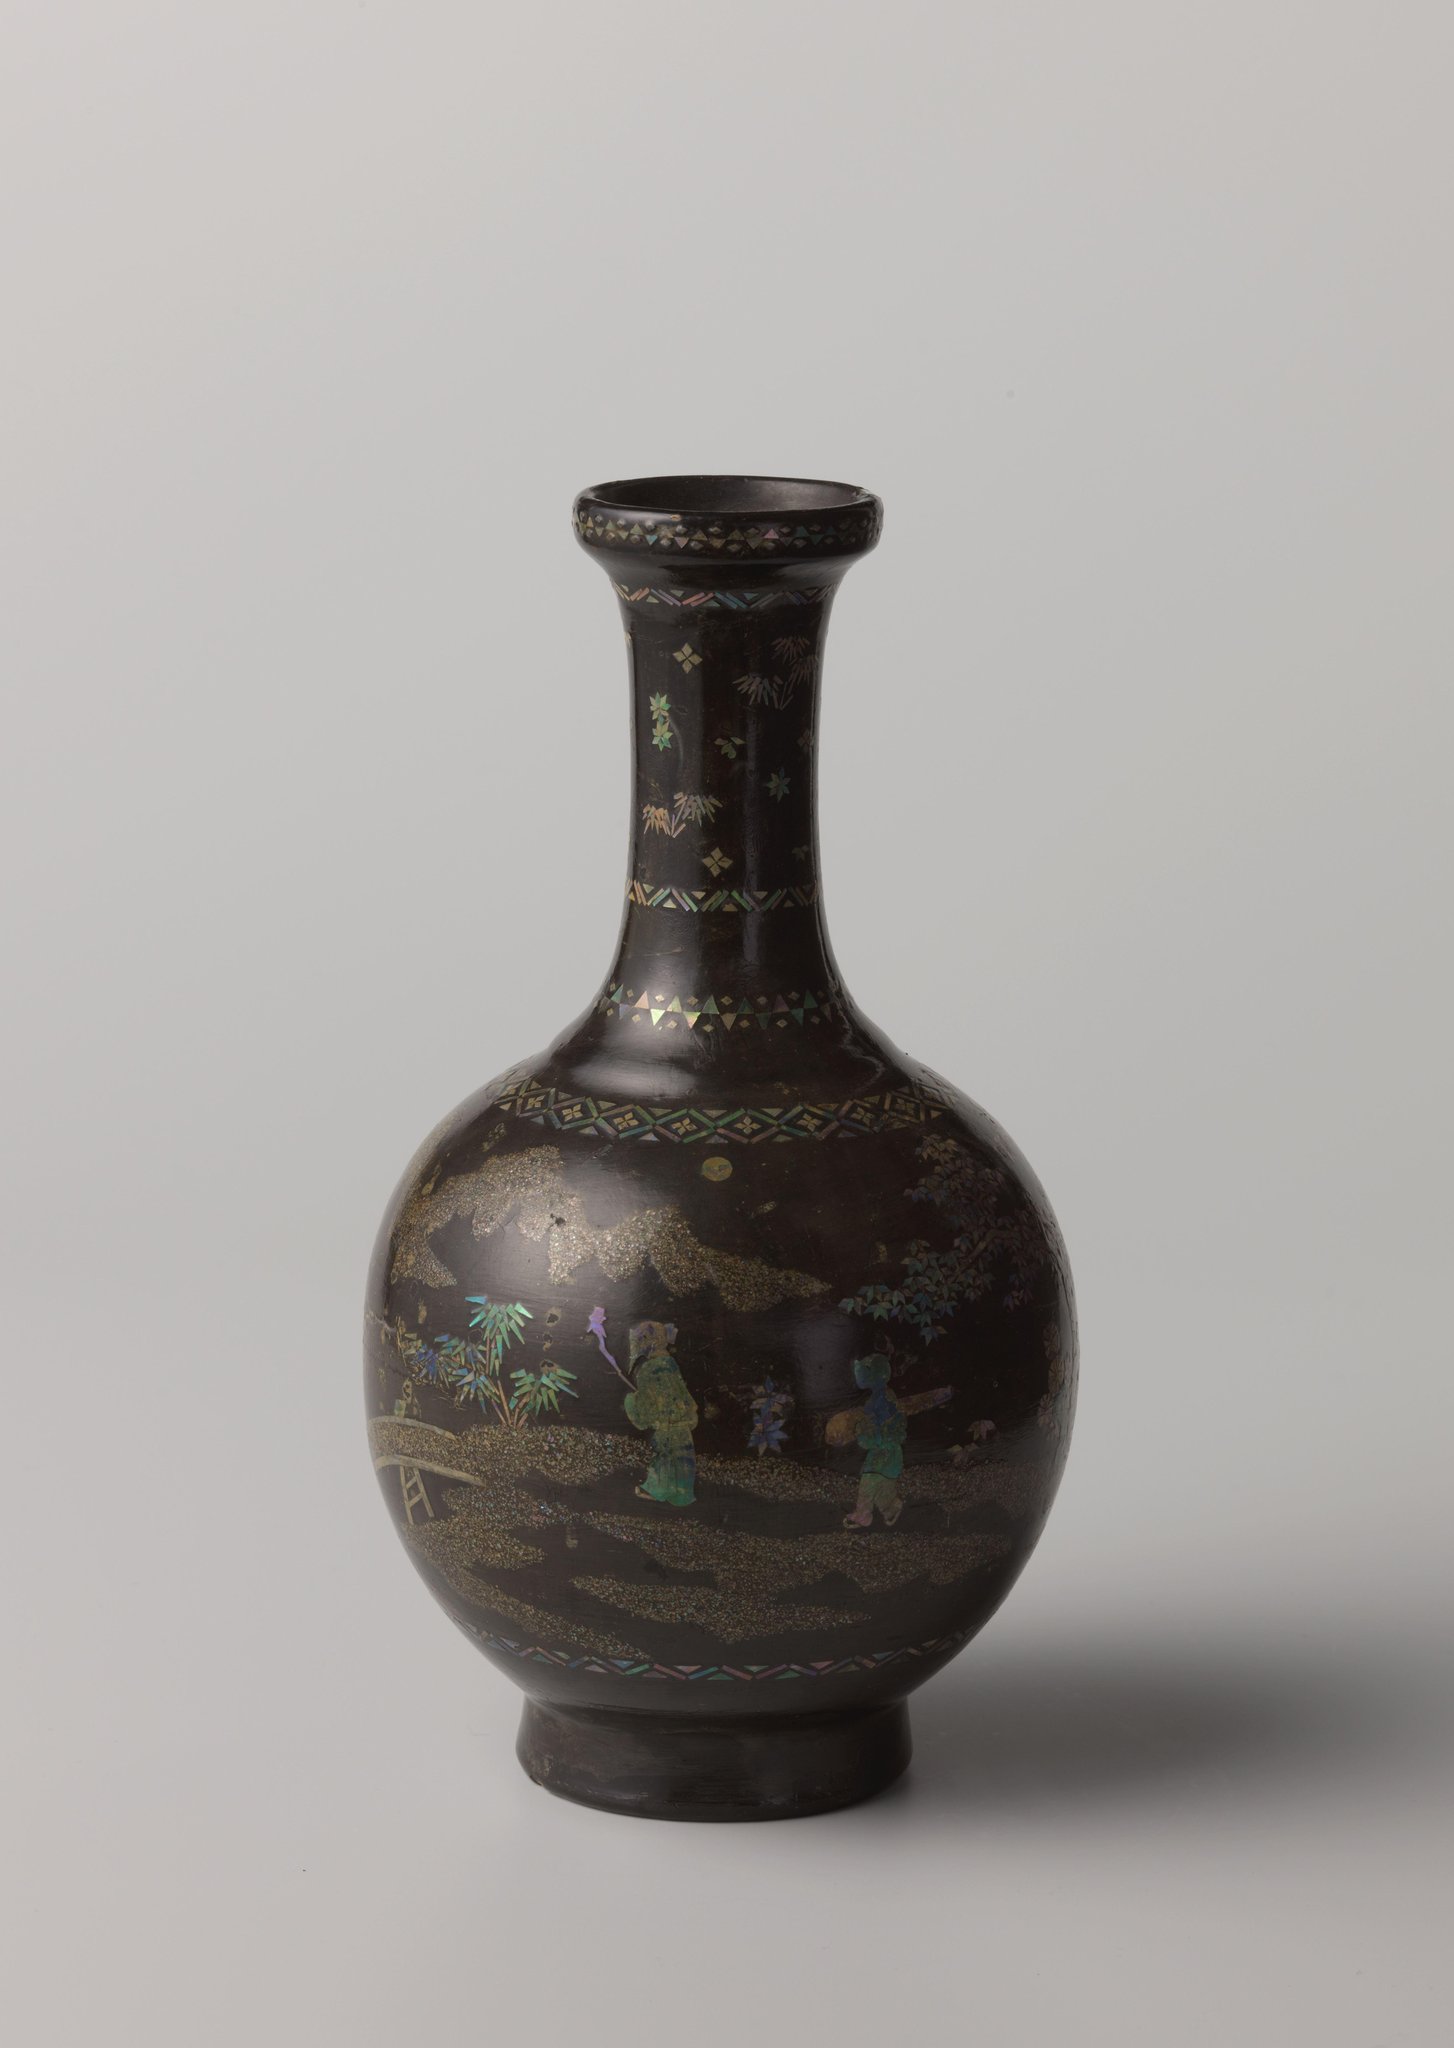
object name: vase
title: Vase with figures in a water landscape and ornamental borders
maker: Anonymous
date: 1700-1799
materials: lacquer, mother of pearl, porcelain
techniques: inlay, lacquer, turning, vitrification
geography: china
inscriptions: mark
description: Vaas van porselein met een bolvormig lichaam, lange hals en opstaande rand, bedekt met zwarte lak ingelegd met parelmoer. Op de buik een rivierlandschap met bomen, rotsen en een brug. Aan de oever een geleerde met achter hem een bediende. Op de schouder, hals en rand decoratieve banden. Gemerkt op de onderzijde met een artemisiablad. Een lakchip in de rand.